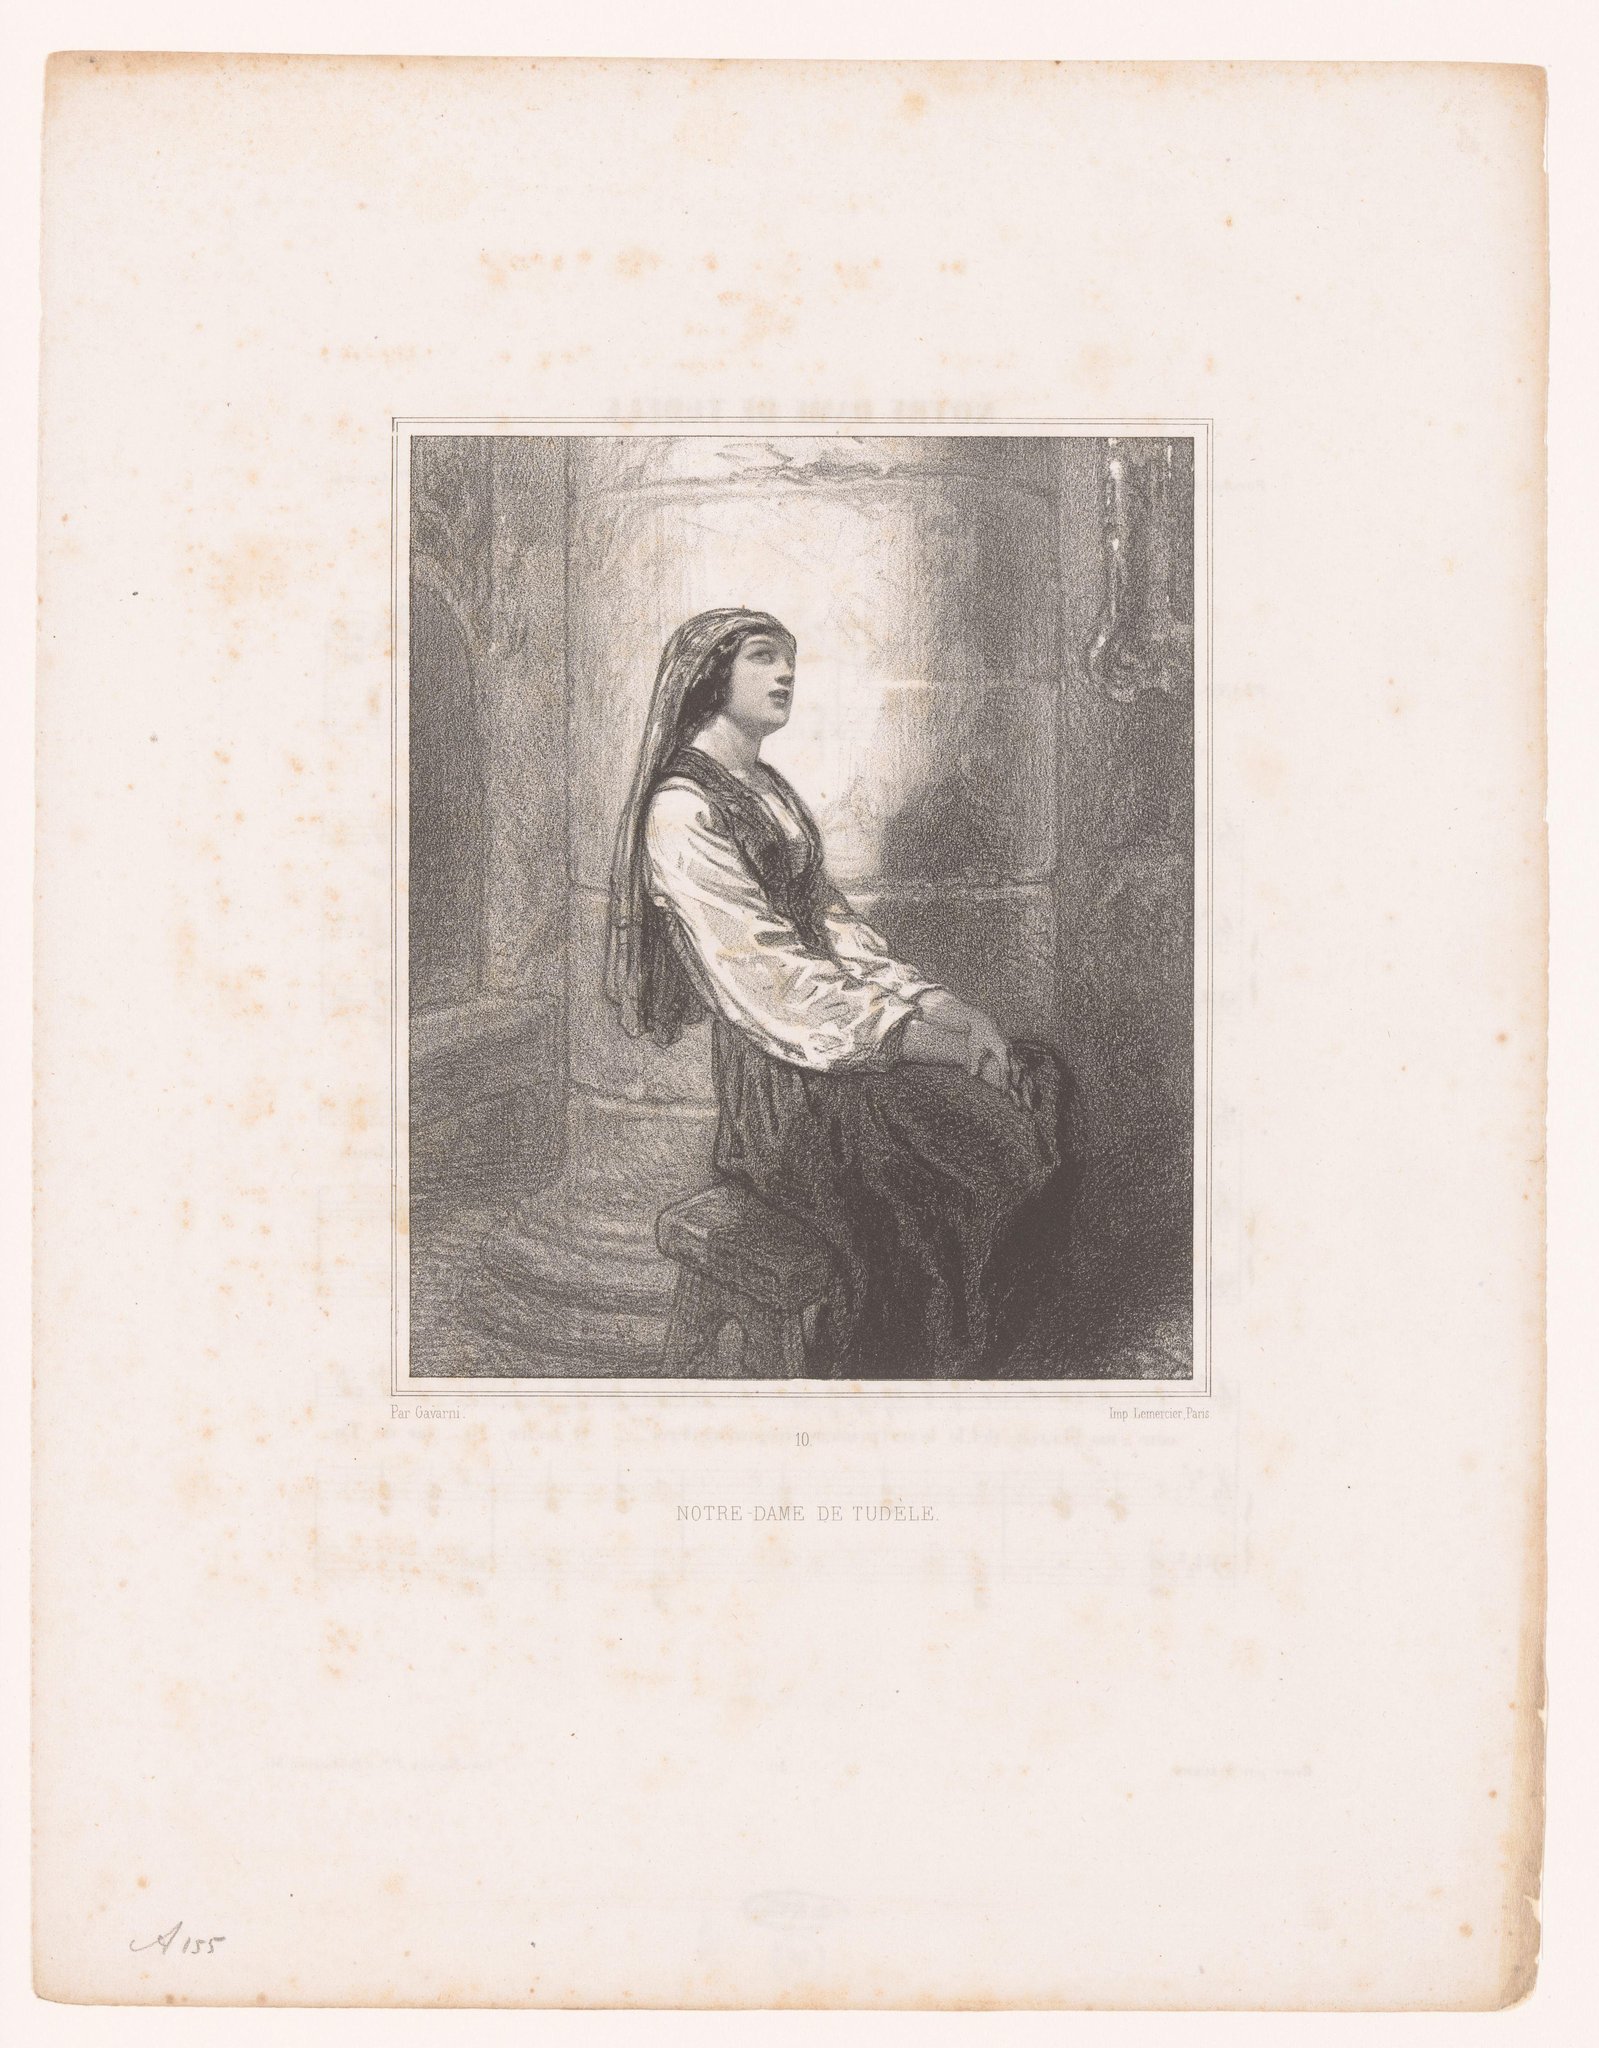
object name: print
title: Jonge vrouw bidt in de kerk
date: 1854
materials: paper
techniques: lithograph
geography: paris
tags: adolescent, young woman, maiden, interior of church, one person praying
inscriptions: collector's mark: Lugt 964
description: Illustratie bij het lied Notre-Dame de Tudèle van M. van Hassets en Jeanne Gavarni.